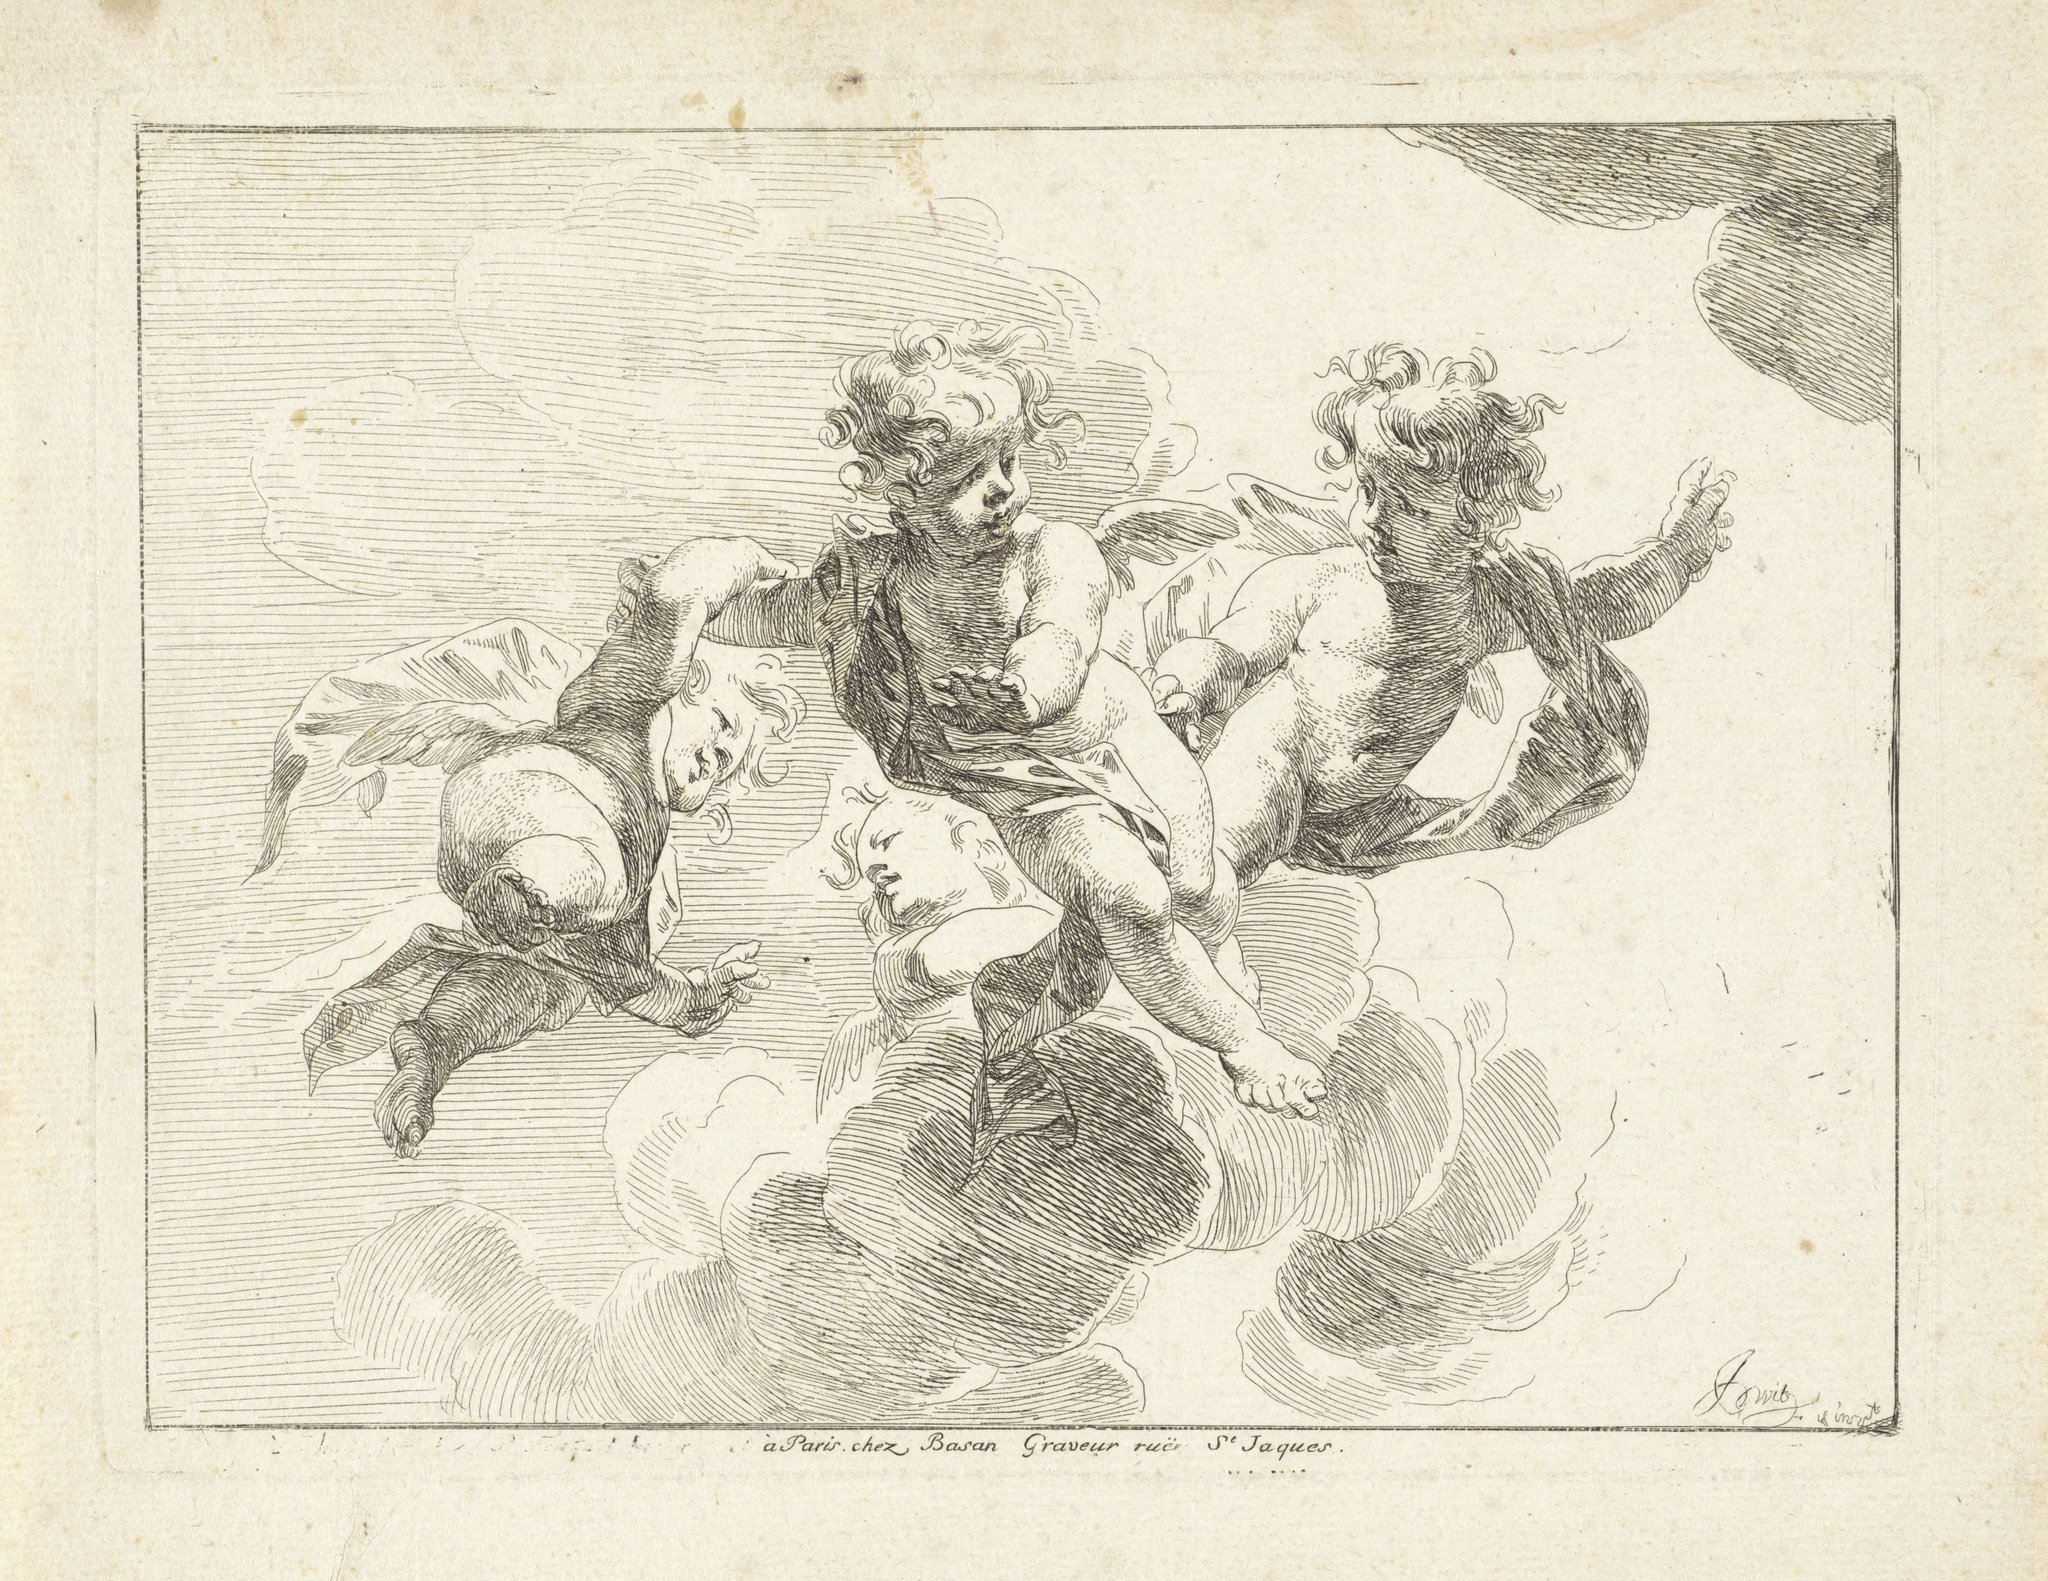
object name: print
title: Vier putti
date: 1760-1799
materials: paper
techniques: etching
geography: paris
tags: cupids: 'amores', 'amoretti', 'putti'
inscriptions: collector's mark: Lugt 240